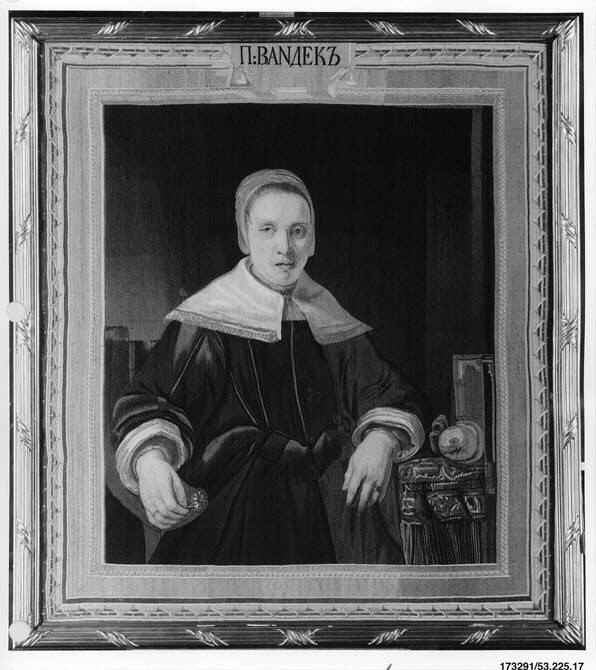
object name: tapestry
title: Young Woman with a Pink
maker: imperial russian tapestry manufactory, saint petersburg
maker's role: manufactory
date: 1767-1800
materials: metal thread, wool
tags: portraits,women